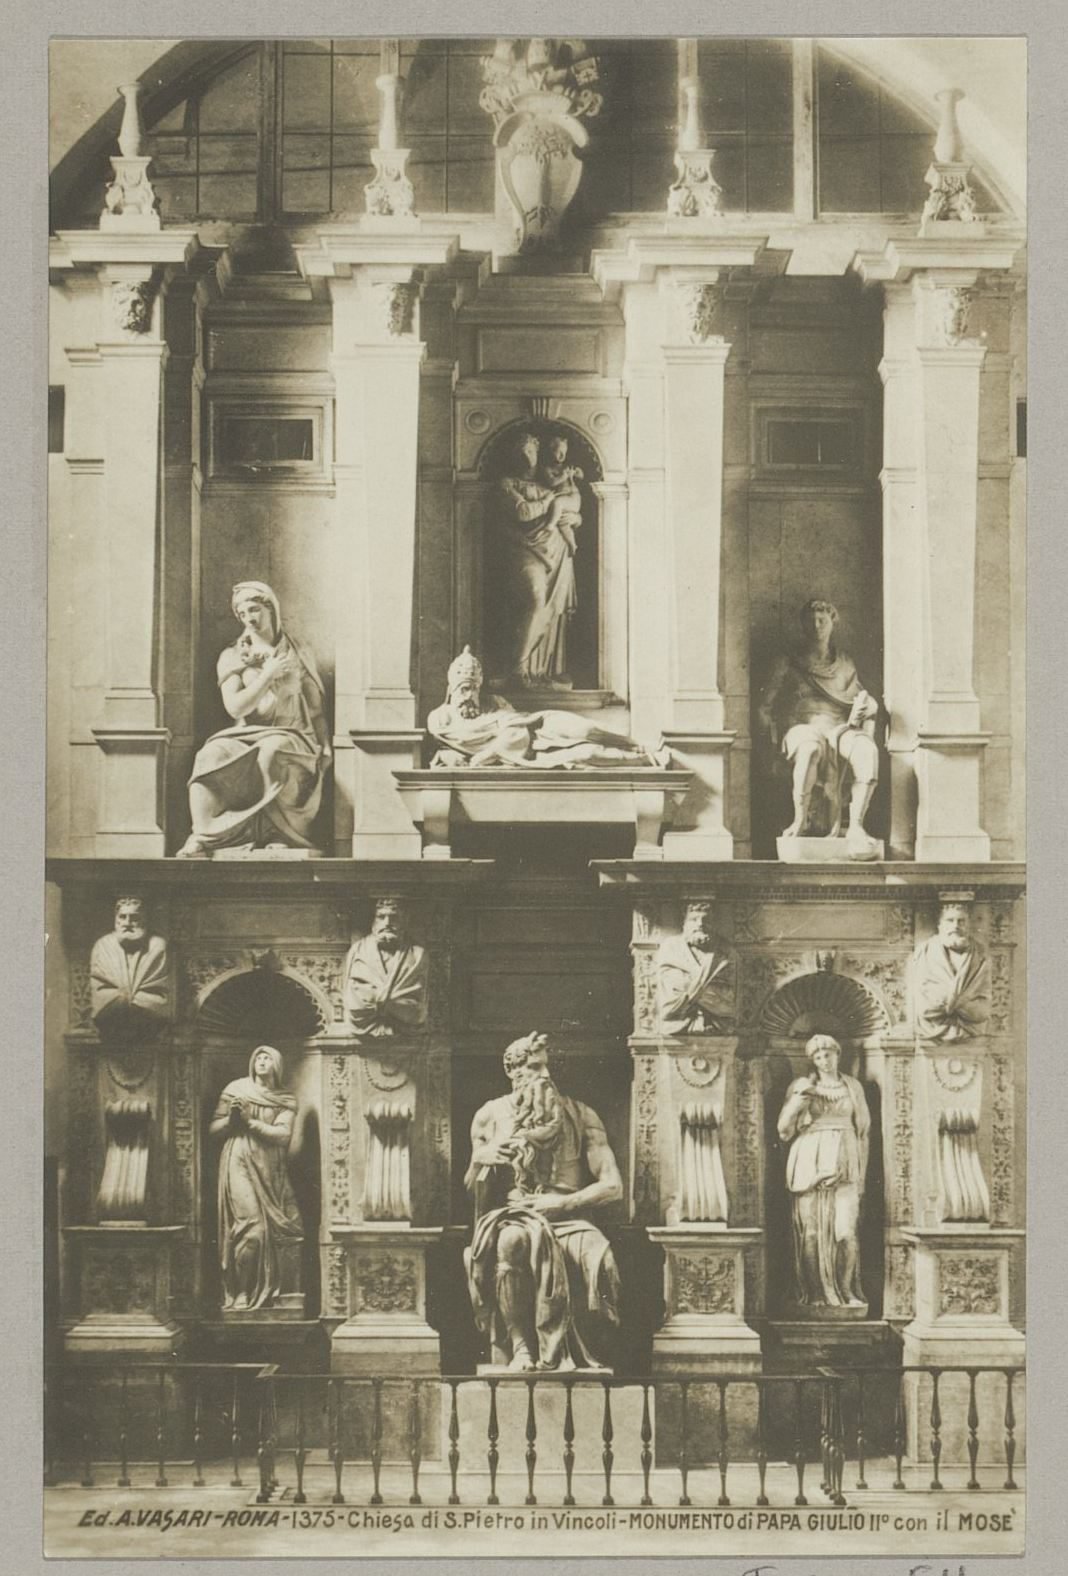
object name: photograph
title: Grafmonument voor paus Julius II met het beeld van Mozes in de San Pietro in Vincoli in Rome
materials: photographic support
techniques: gelatin silver print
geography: san pietro in vincoli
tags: grave, tomb, piece of sculpture, reproduction of a piece of sculpture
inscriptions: number: ‘1375’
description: Onderdeel van Fotoalbum van een reis door Zuid-Europa en het Midden-Oosten.